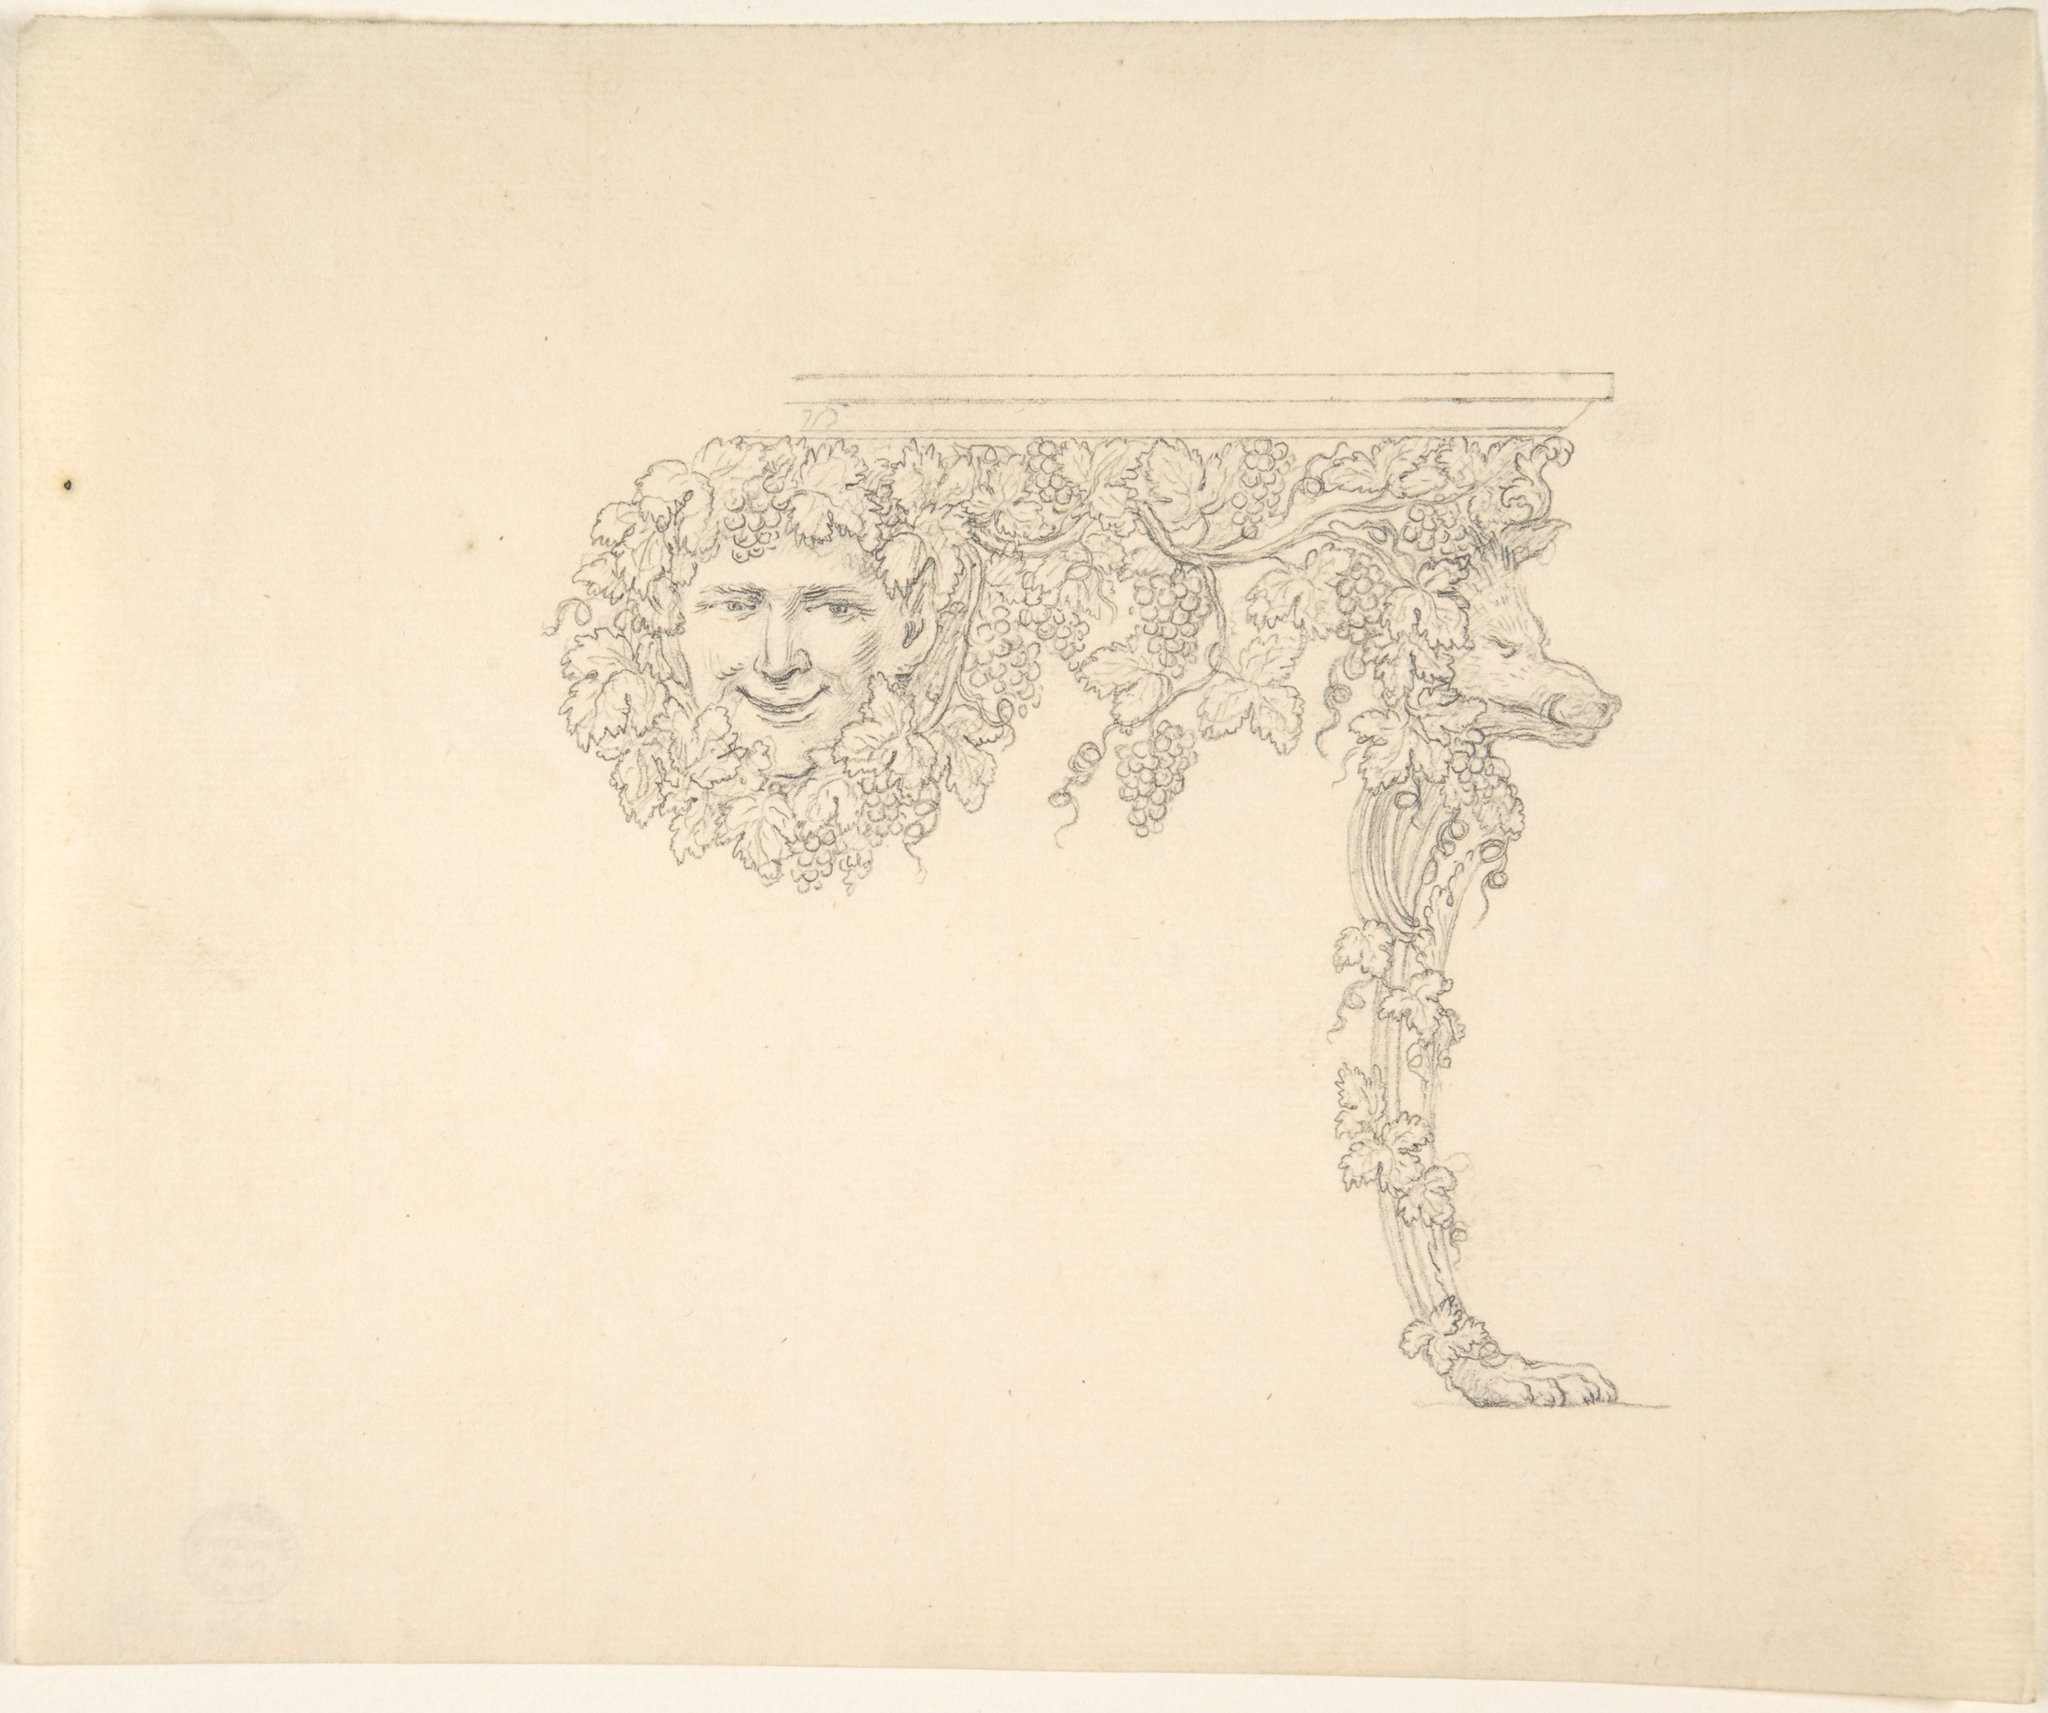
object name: drawing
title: Table Design with Bacchus and Boar's head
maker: anonymous, british, 19th century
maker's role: artist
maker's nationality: british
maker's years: 1800-1900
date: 1801-1900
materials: graphite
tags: grapes,bacchus,boars,leaves